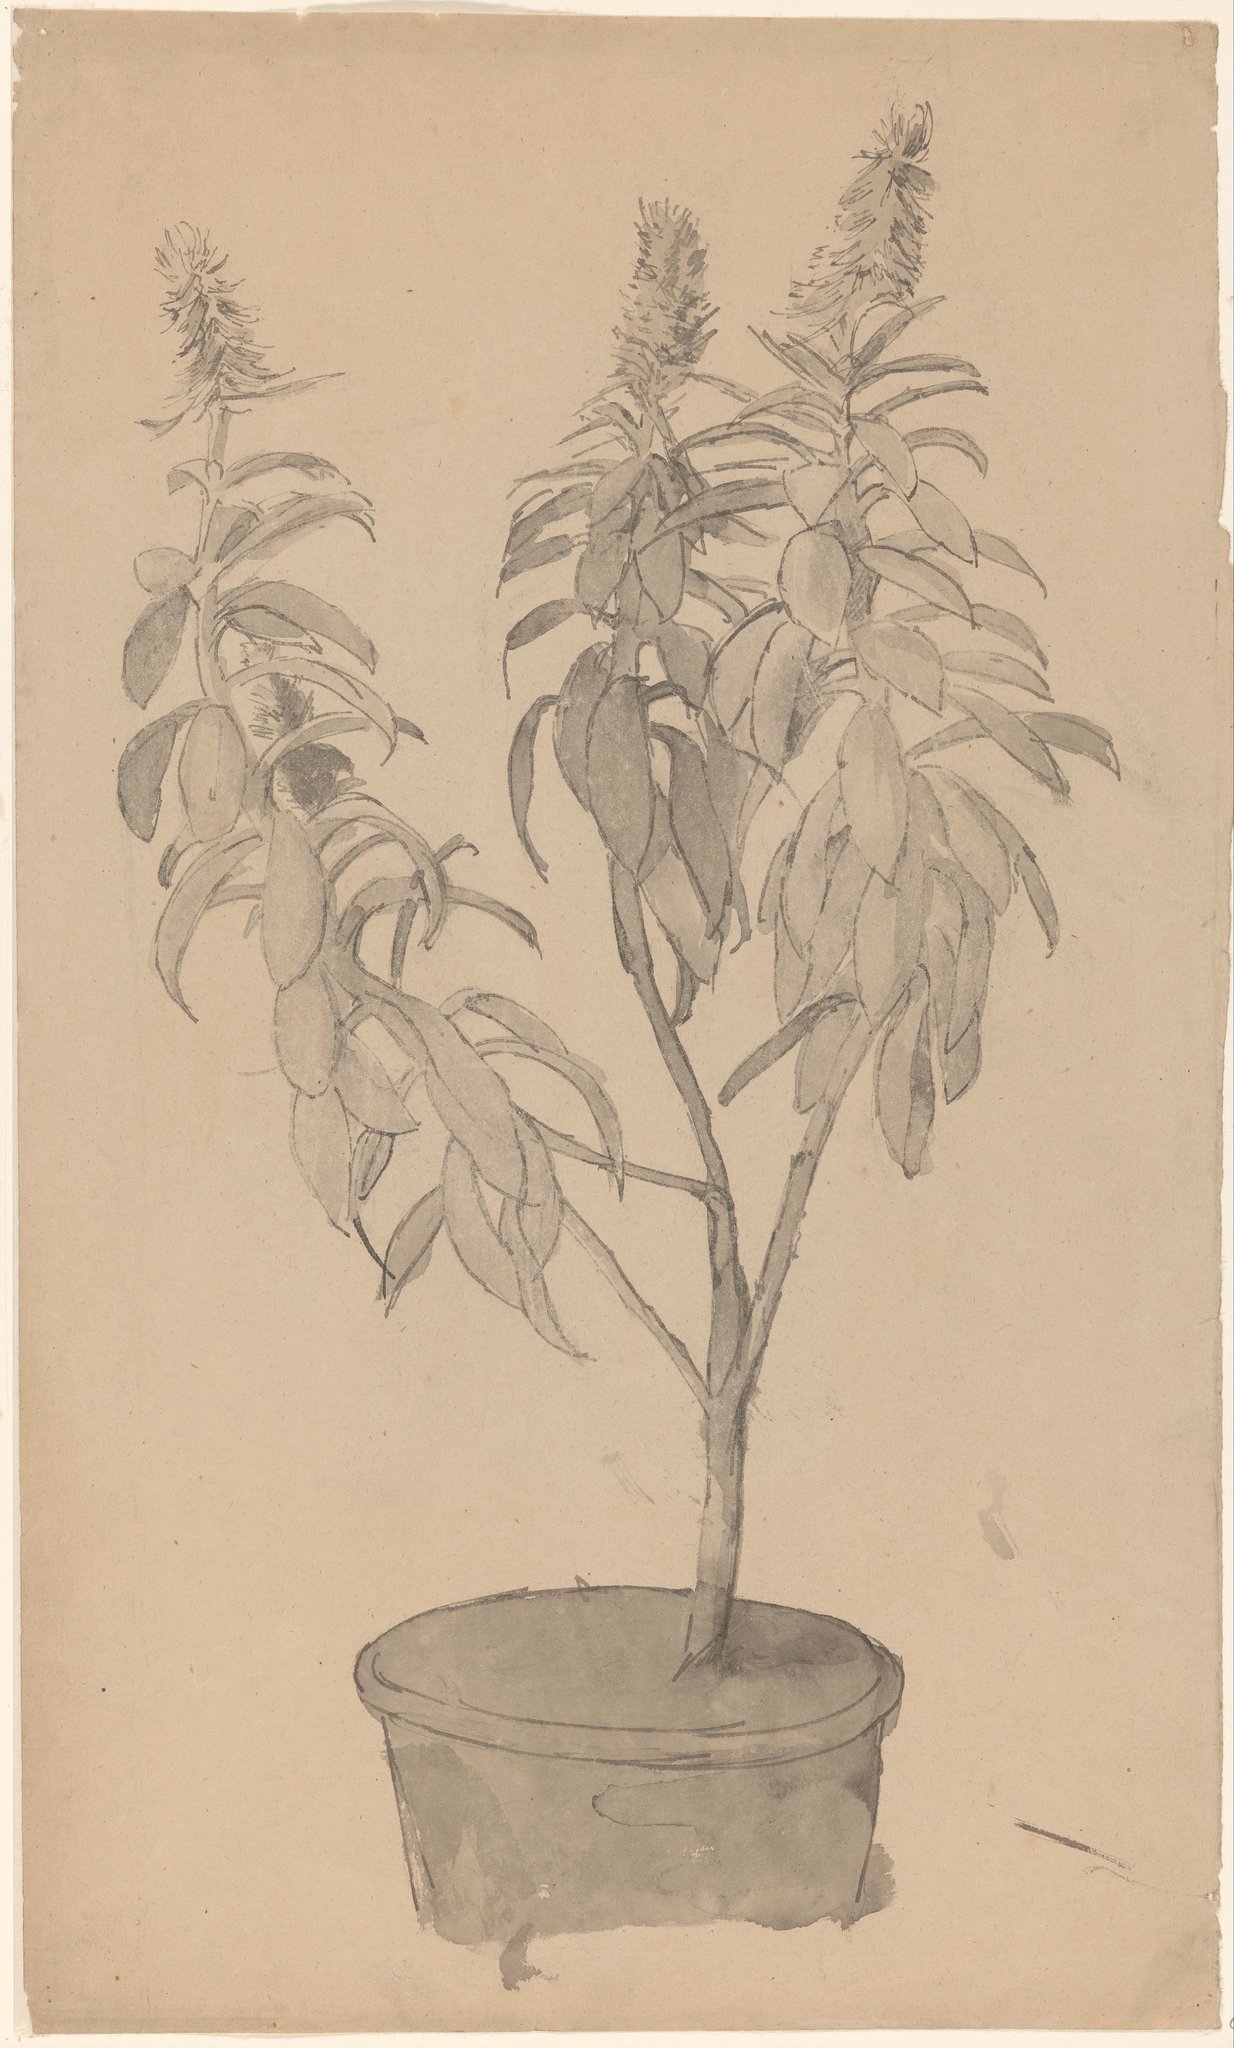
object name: drawing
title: Bloeiende potplant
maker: cornelis gerardus t hooft (1791-1871)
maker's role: draughtsman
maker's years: 1791-1871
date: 1801-1871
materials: ink, paper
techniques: brush, pen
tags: plants and herbs